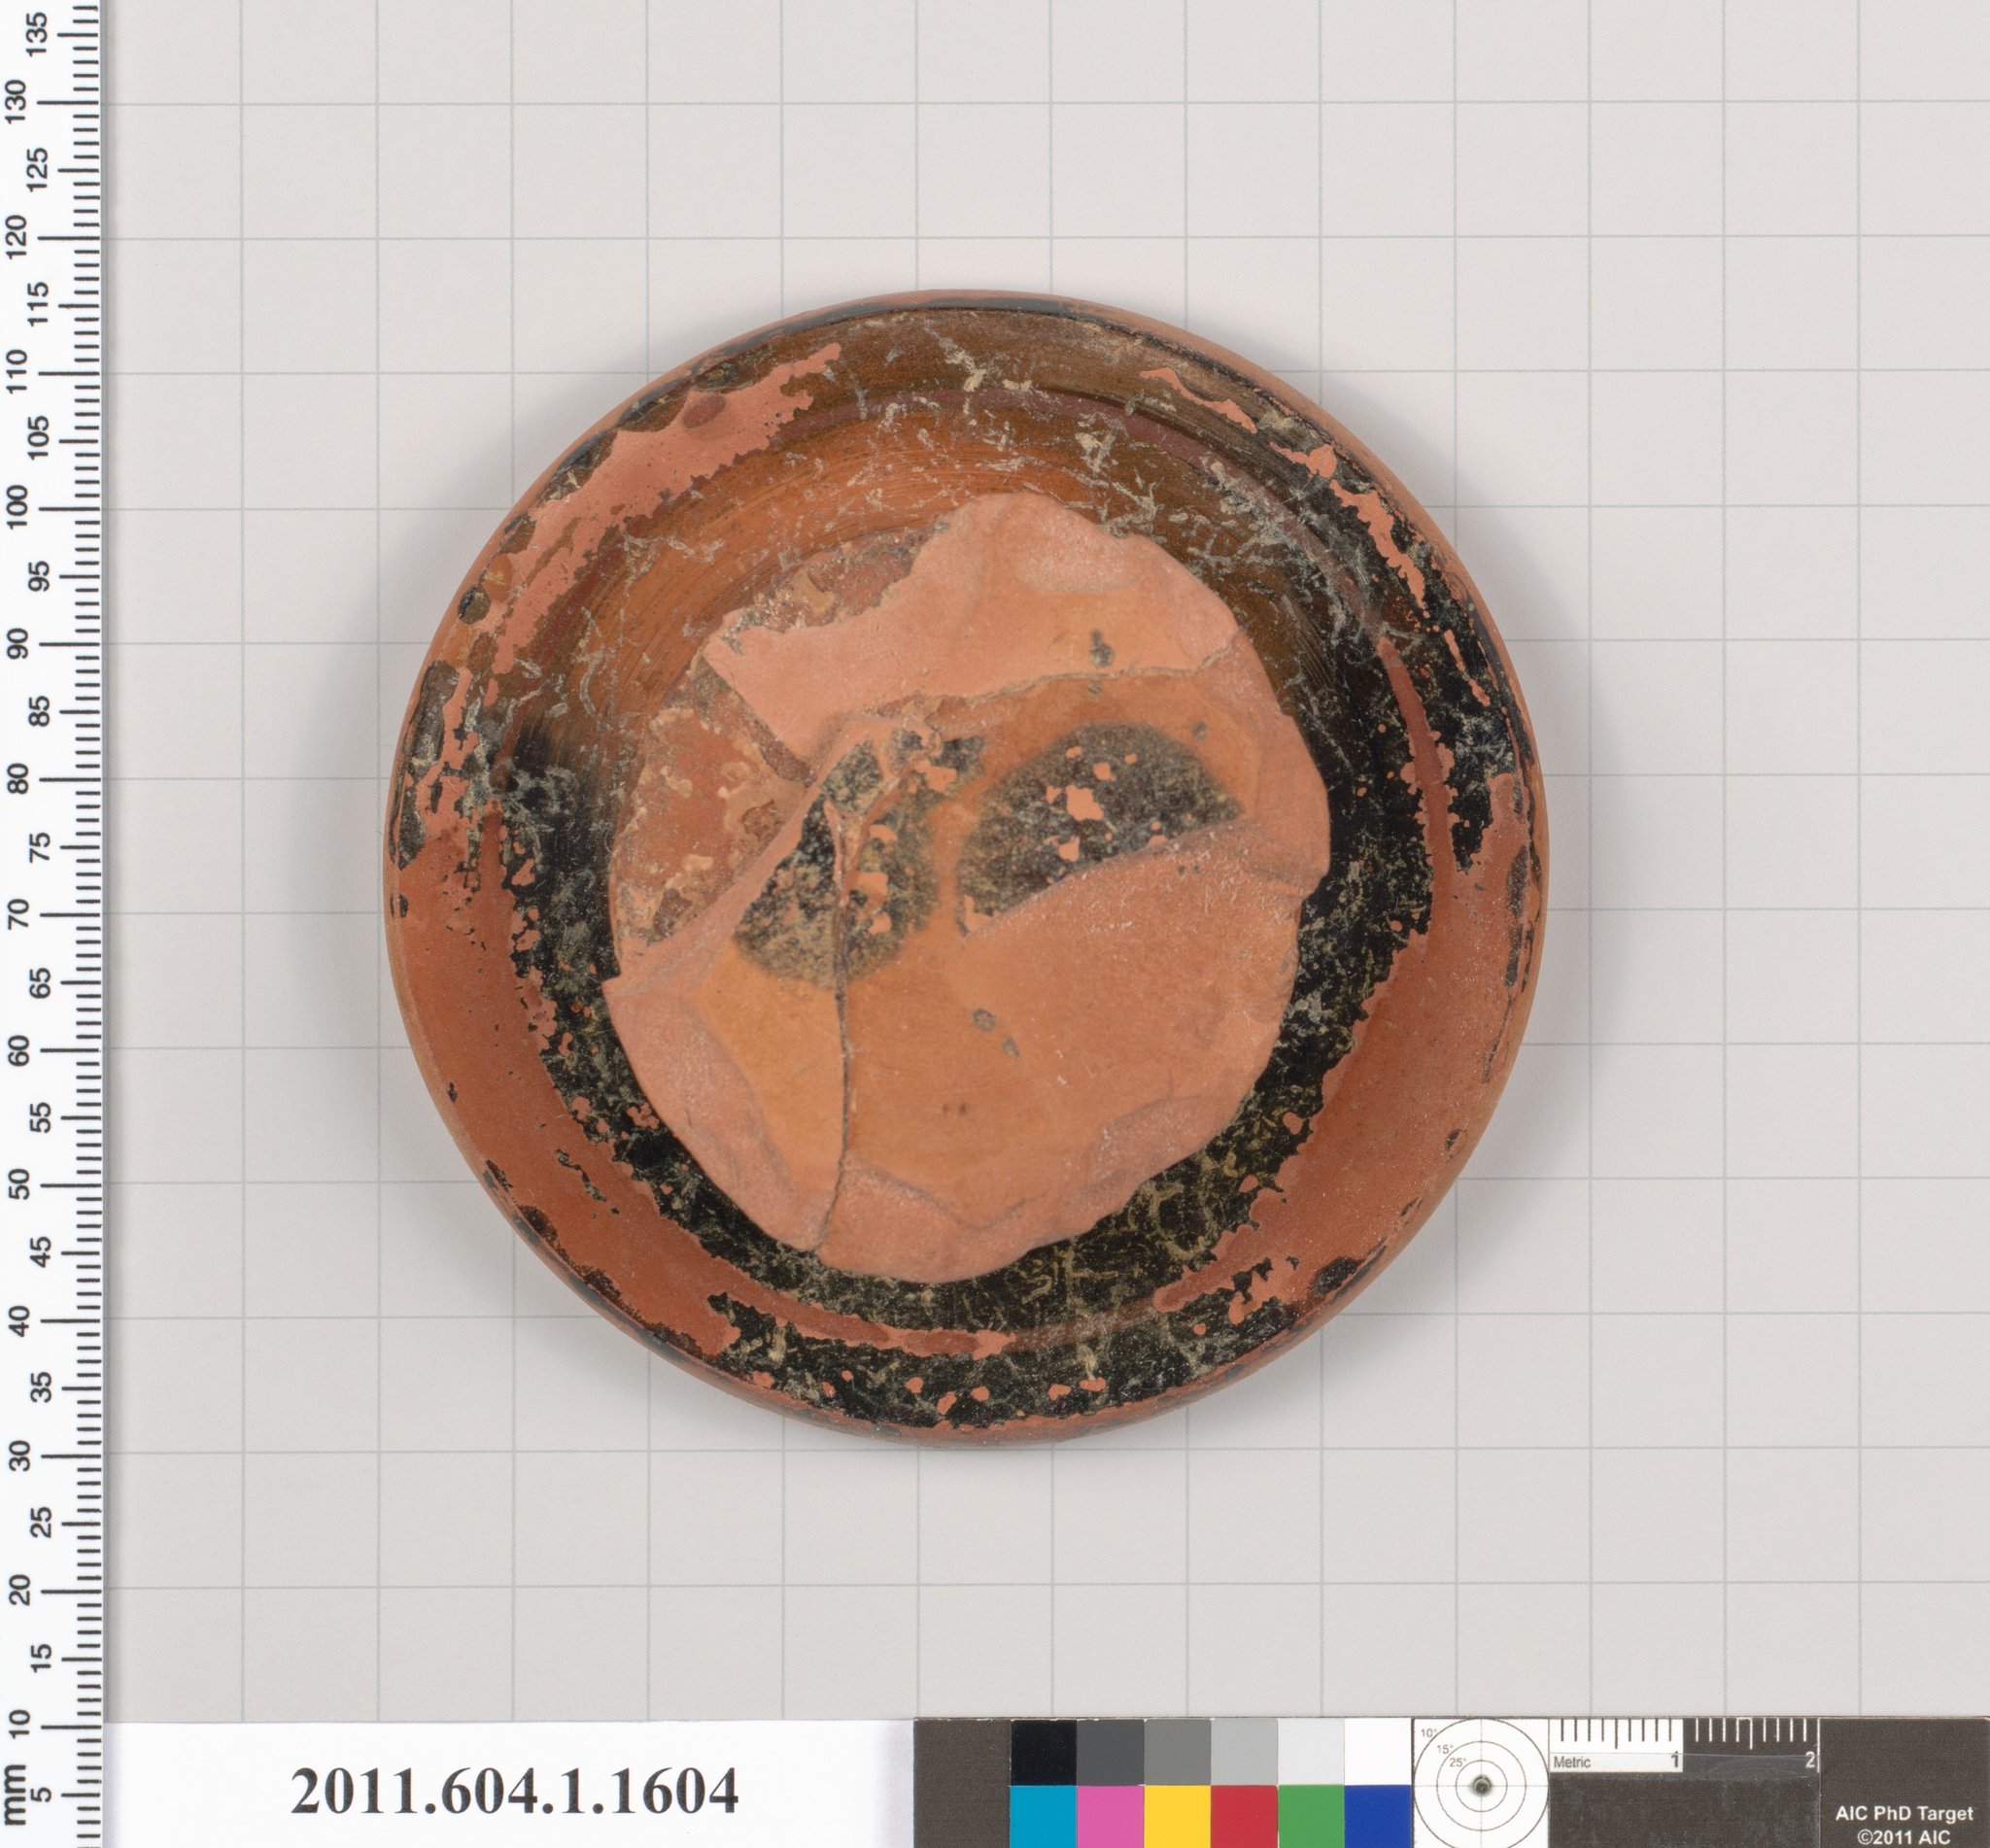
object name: kylix fragment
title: Terracotta fragment of a kylix (drinking cup)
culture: greek, attic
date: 500-401 BCE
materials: terracotta